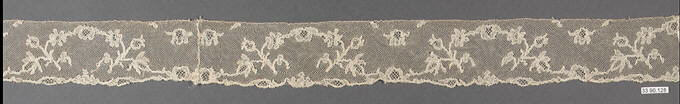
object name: edging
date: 1734-1766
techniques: lace